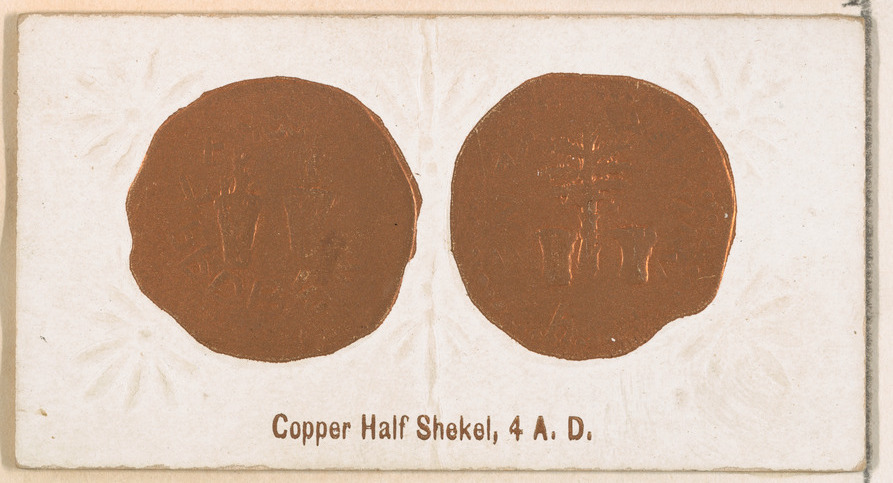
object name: print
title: Copper Half Shekel, 4 A.D., from the Ancient Coins series (N180) issued by Wm. S. Kimball & Co.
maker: william s. kimball & company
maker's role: publisher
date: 1888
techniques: color lithograph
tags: coins